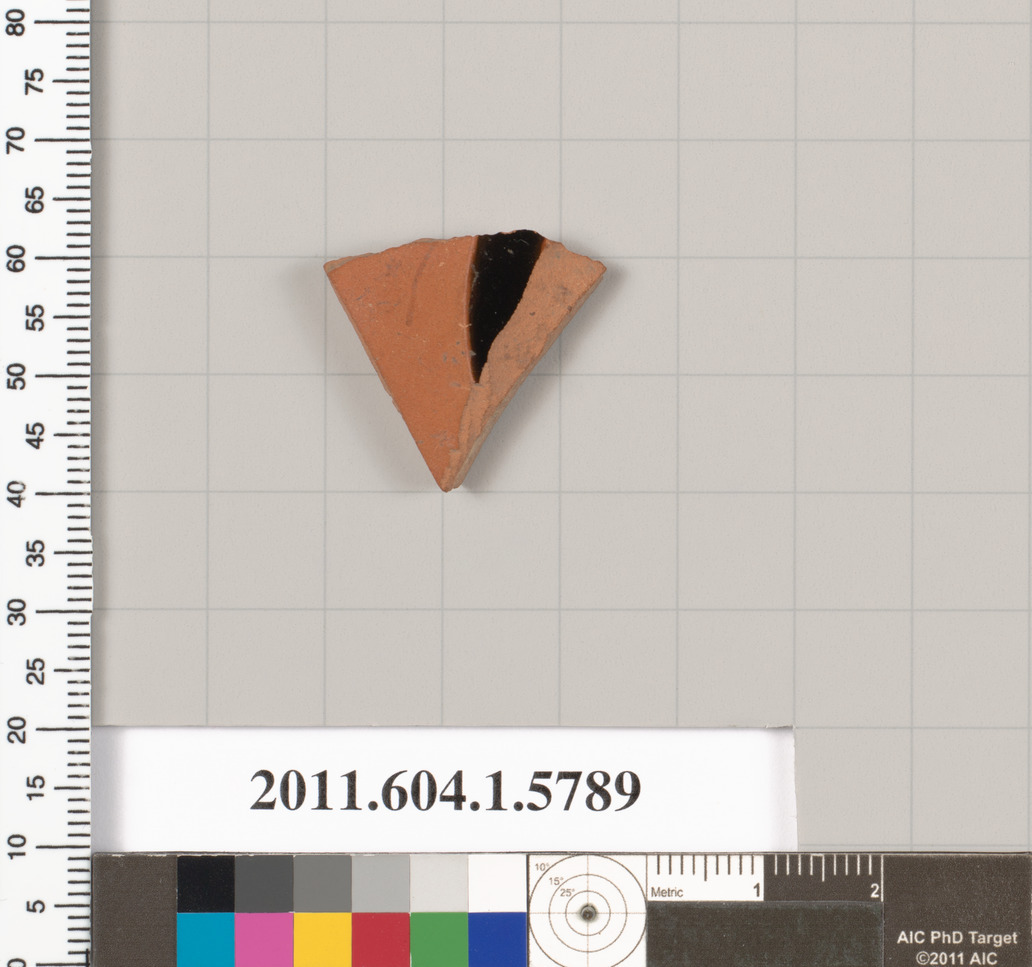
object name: kylix fragment, eye cup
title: Terracotta fragment of a kylix: eye-cup (drinking cup)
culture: greek, attic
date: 525-510 BCE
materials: terracotta